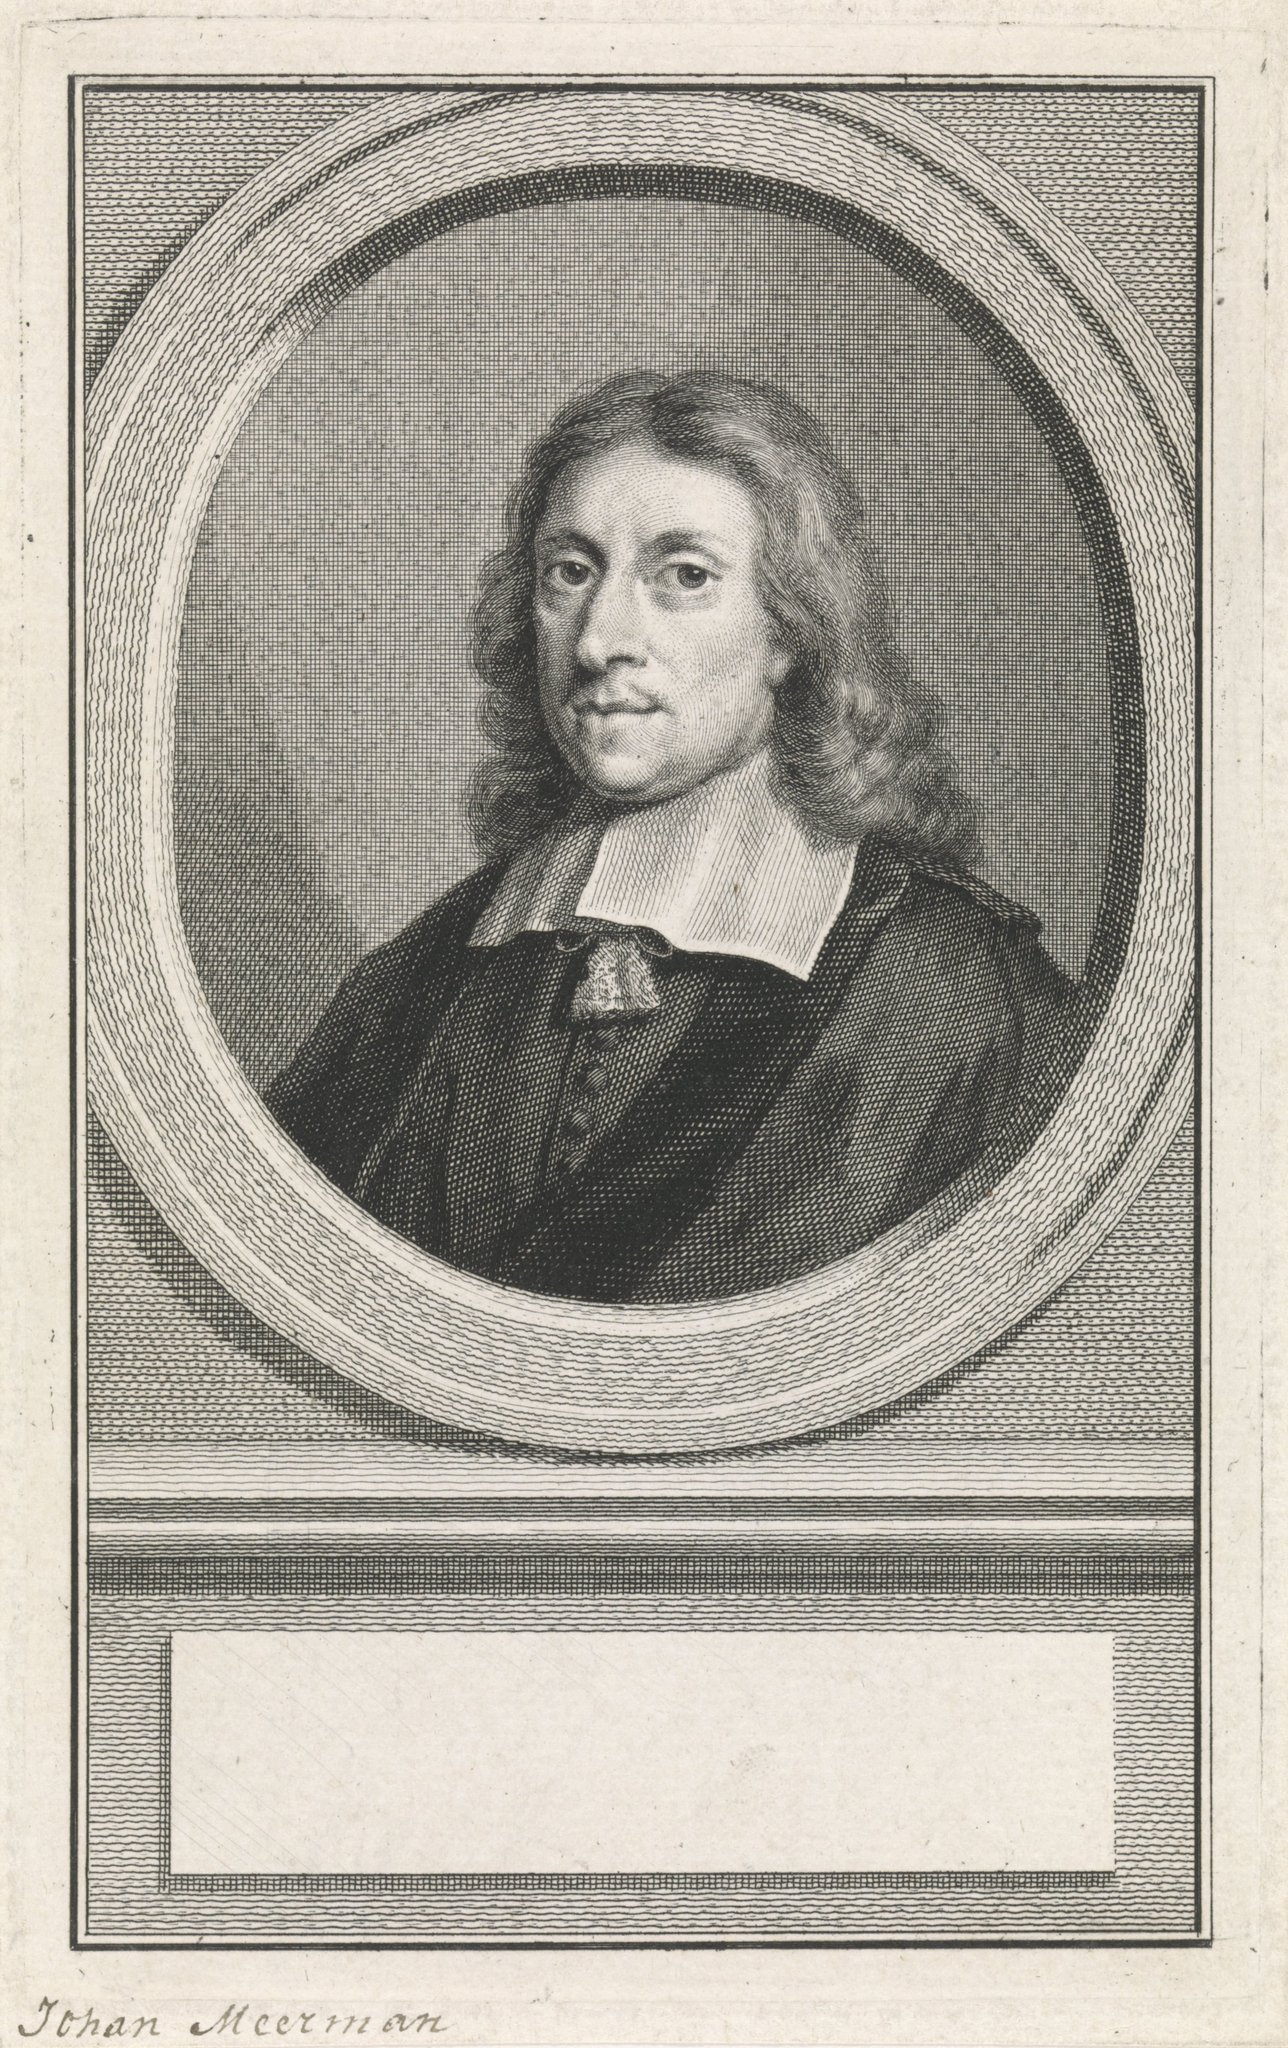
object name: print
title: Portret van Johan Meerman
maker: jacob houbraken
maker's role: draughtsman, print maker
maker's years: 1698-1780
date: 1747-1759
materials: paper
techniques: engraving, etching, pen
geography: amsterdam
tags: leiden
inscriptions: collector's mark: Lugt 2228, name: ‘Johan Meerman’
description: Proefdruk van de prent gebruikt in: Jan Wagenaar, Vaderlandsche historie, vervattende de geschiedenissen der nu Vereenigde Nederlanden, inzonderheid die van Holland (...), 21 delen. Amsterdam, Isaak Tirion, 1749-59.